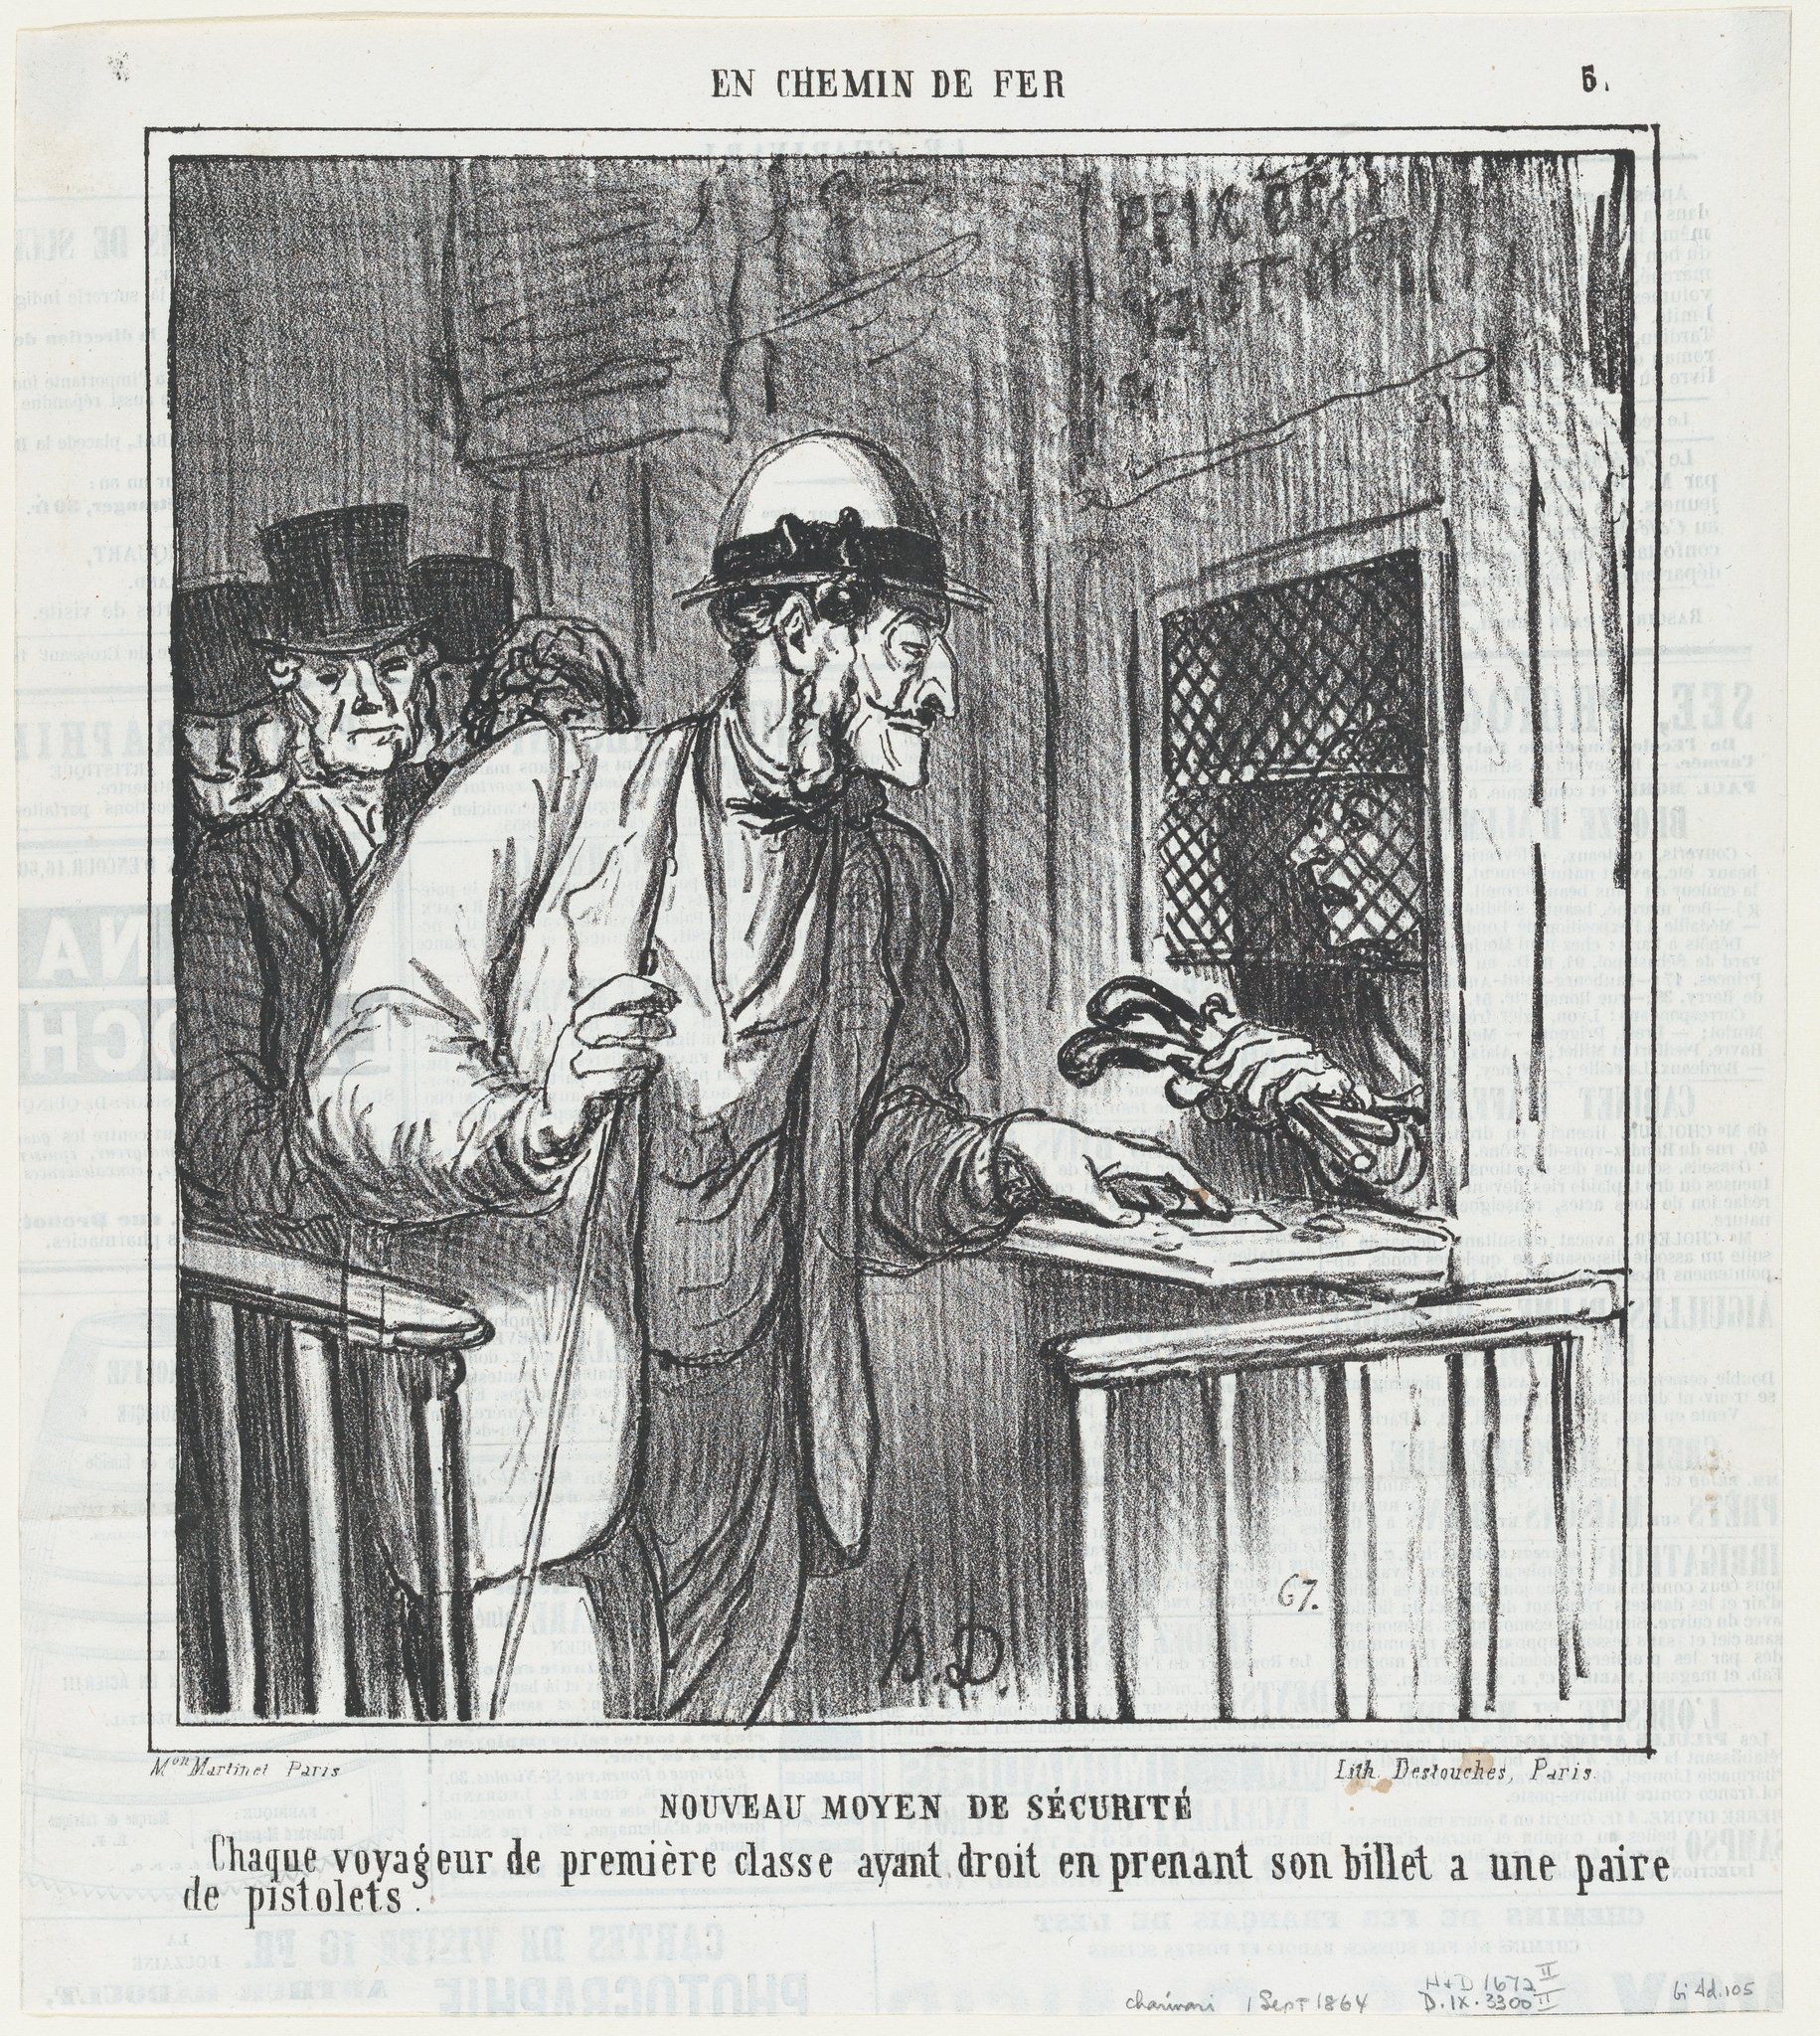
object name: print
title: New security measures, from 'On the train,' published in Le Charivari, September 1, 1864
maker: honoré daumier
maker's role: artist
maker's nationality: french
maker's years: 1808-1879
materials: paper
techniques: lithograph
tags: satire,men